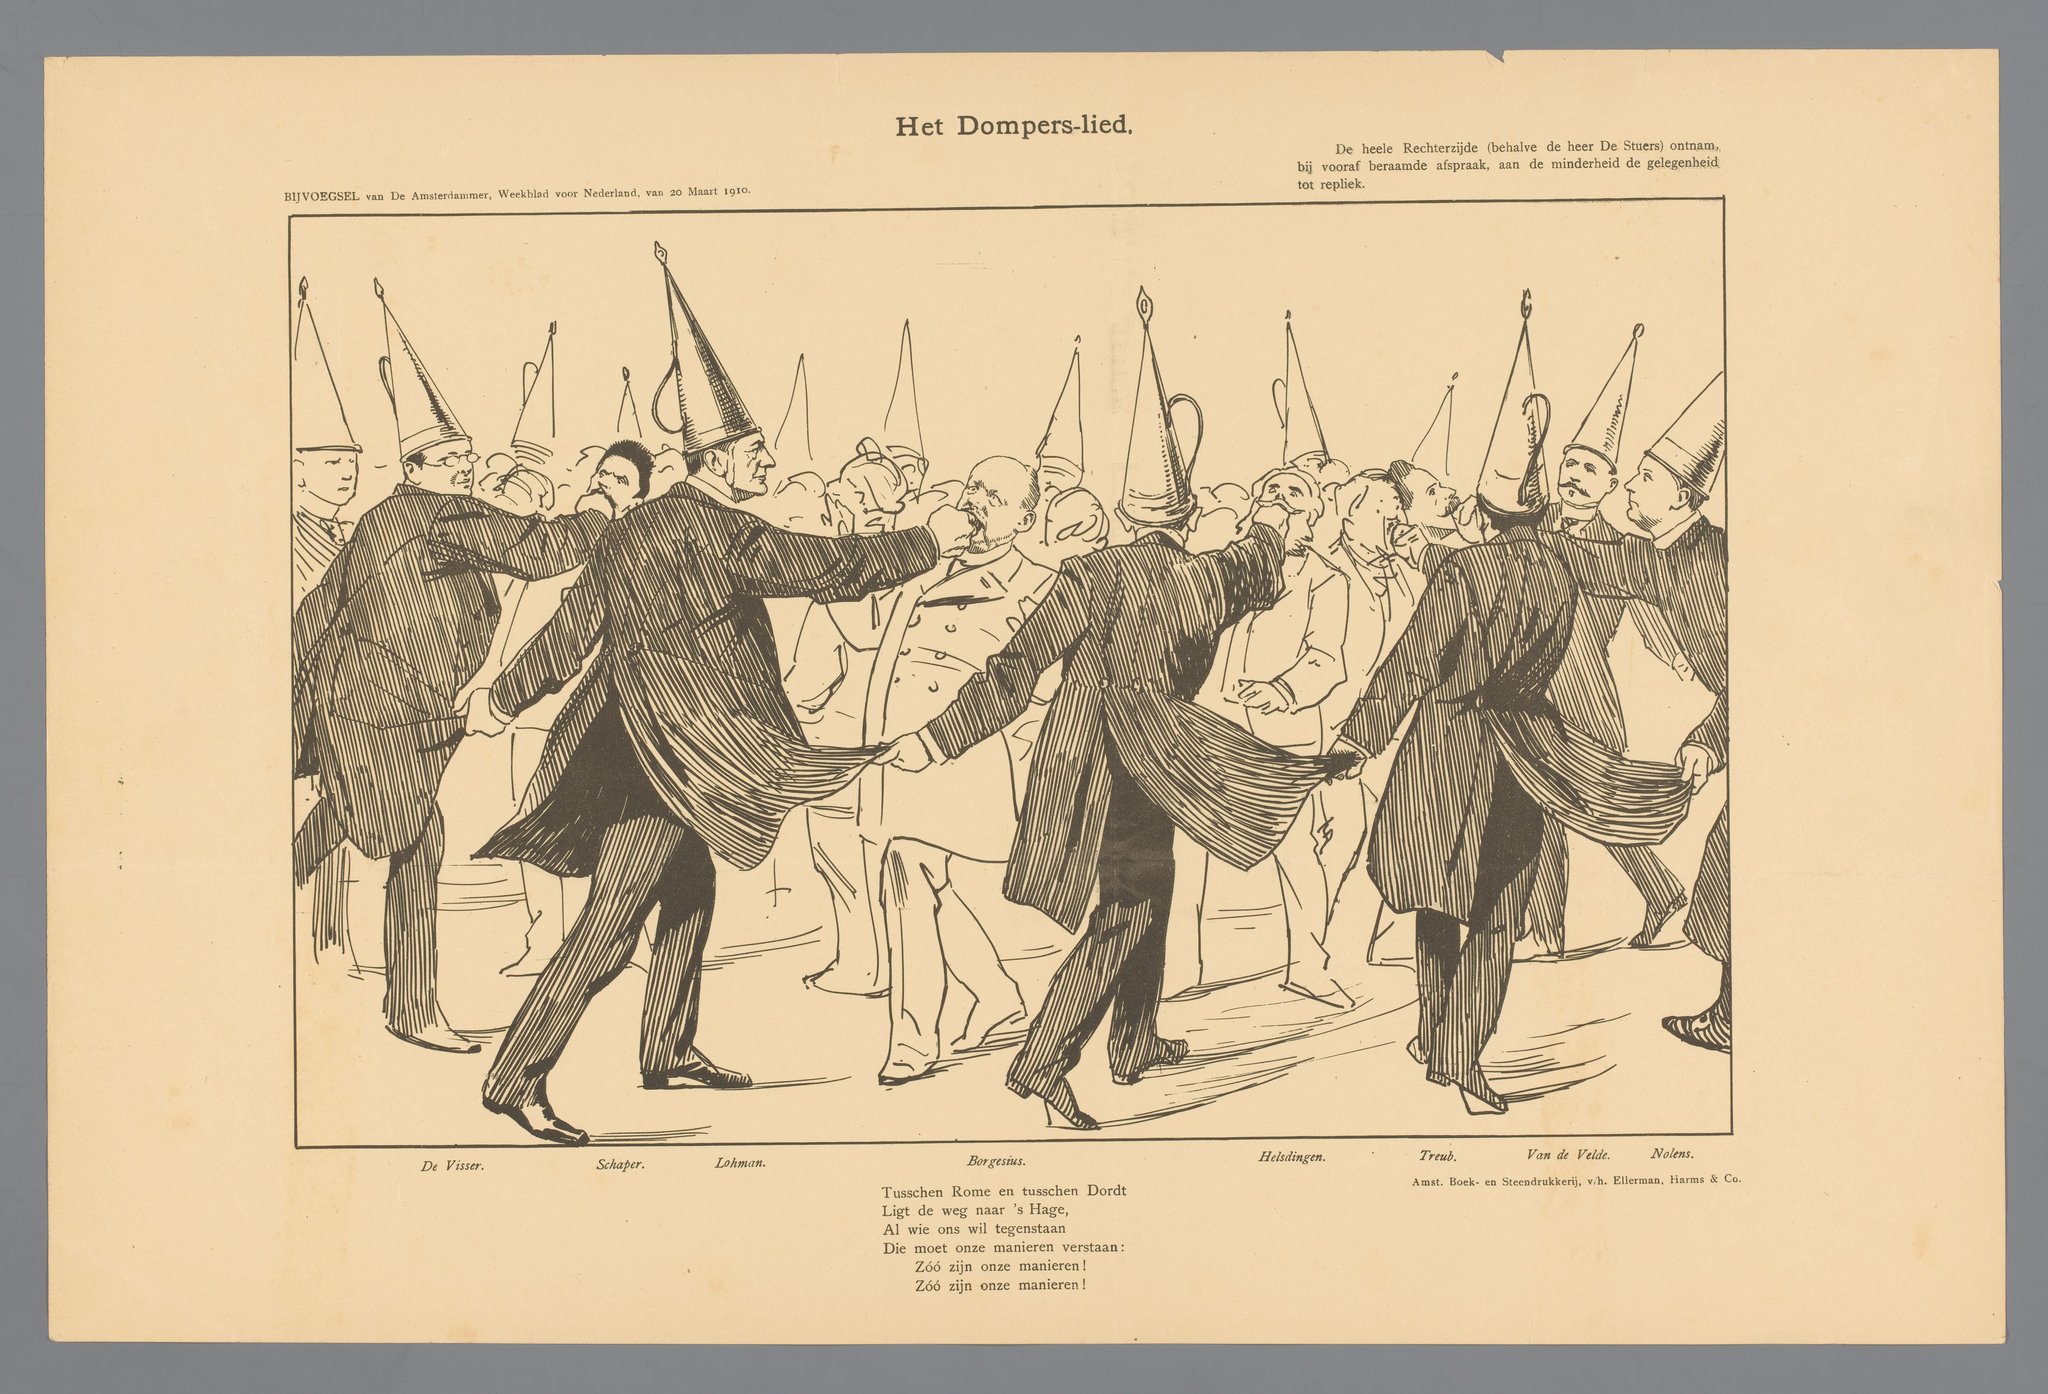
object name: cartoon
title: Het Dompers-lied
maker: johan braakensiek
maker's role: draughtsman, print maker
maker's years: 1858-1940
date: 1910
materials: paper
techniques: lithograph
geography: amsterdam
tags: politician, the hague, jonkheer alexander frederik de savornin lohman, priest, voorschoten, utrecht, historical persons, political caricatures and satires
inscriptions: date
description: Prent uit het bijvoegsel van: De Amsterdammer. Weekblad voor Nederland, 20 maart 1910.